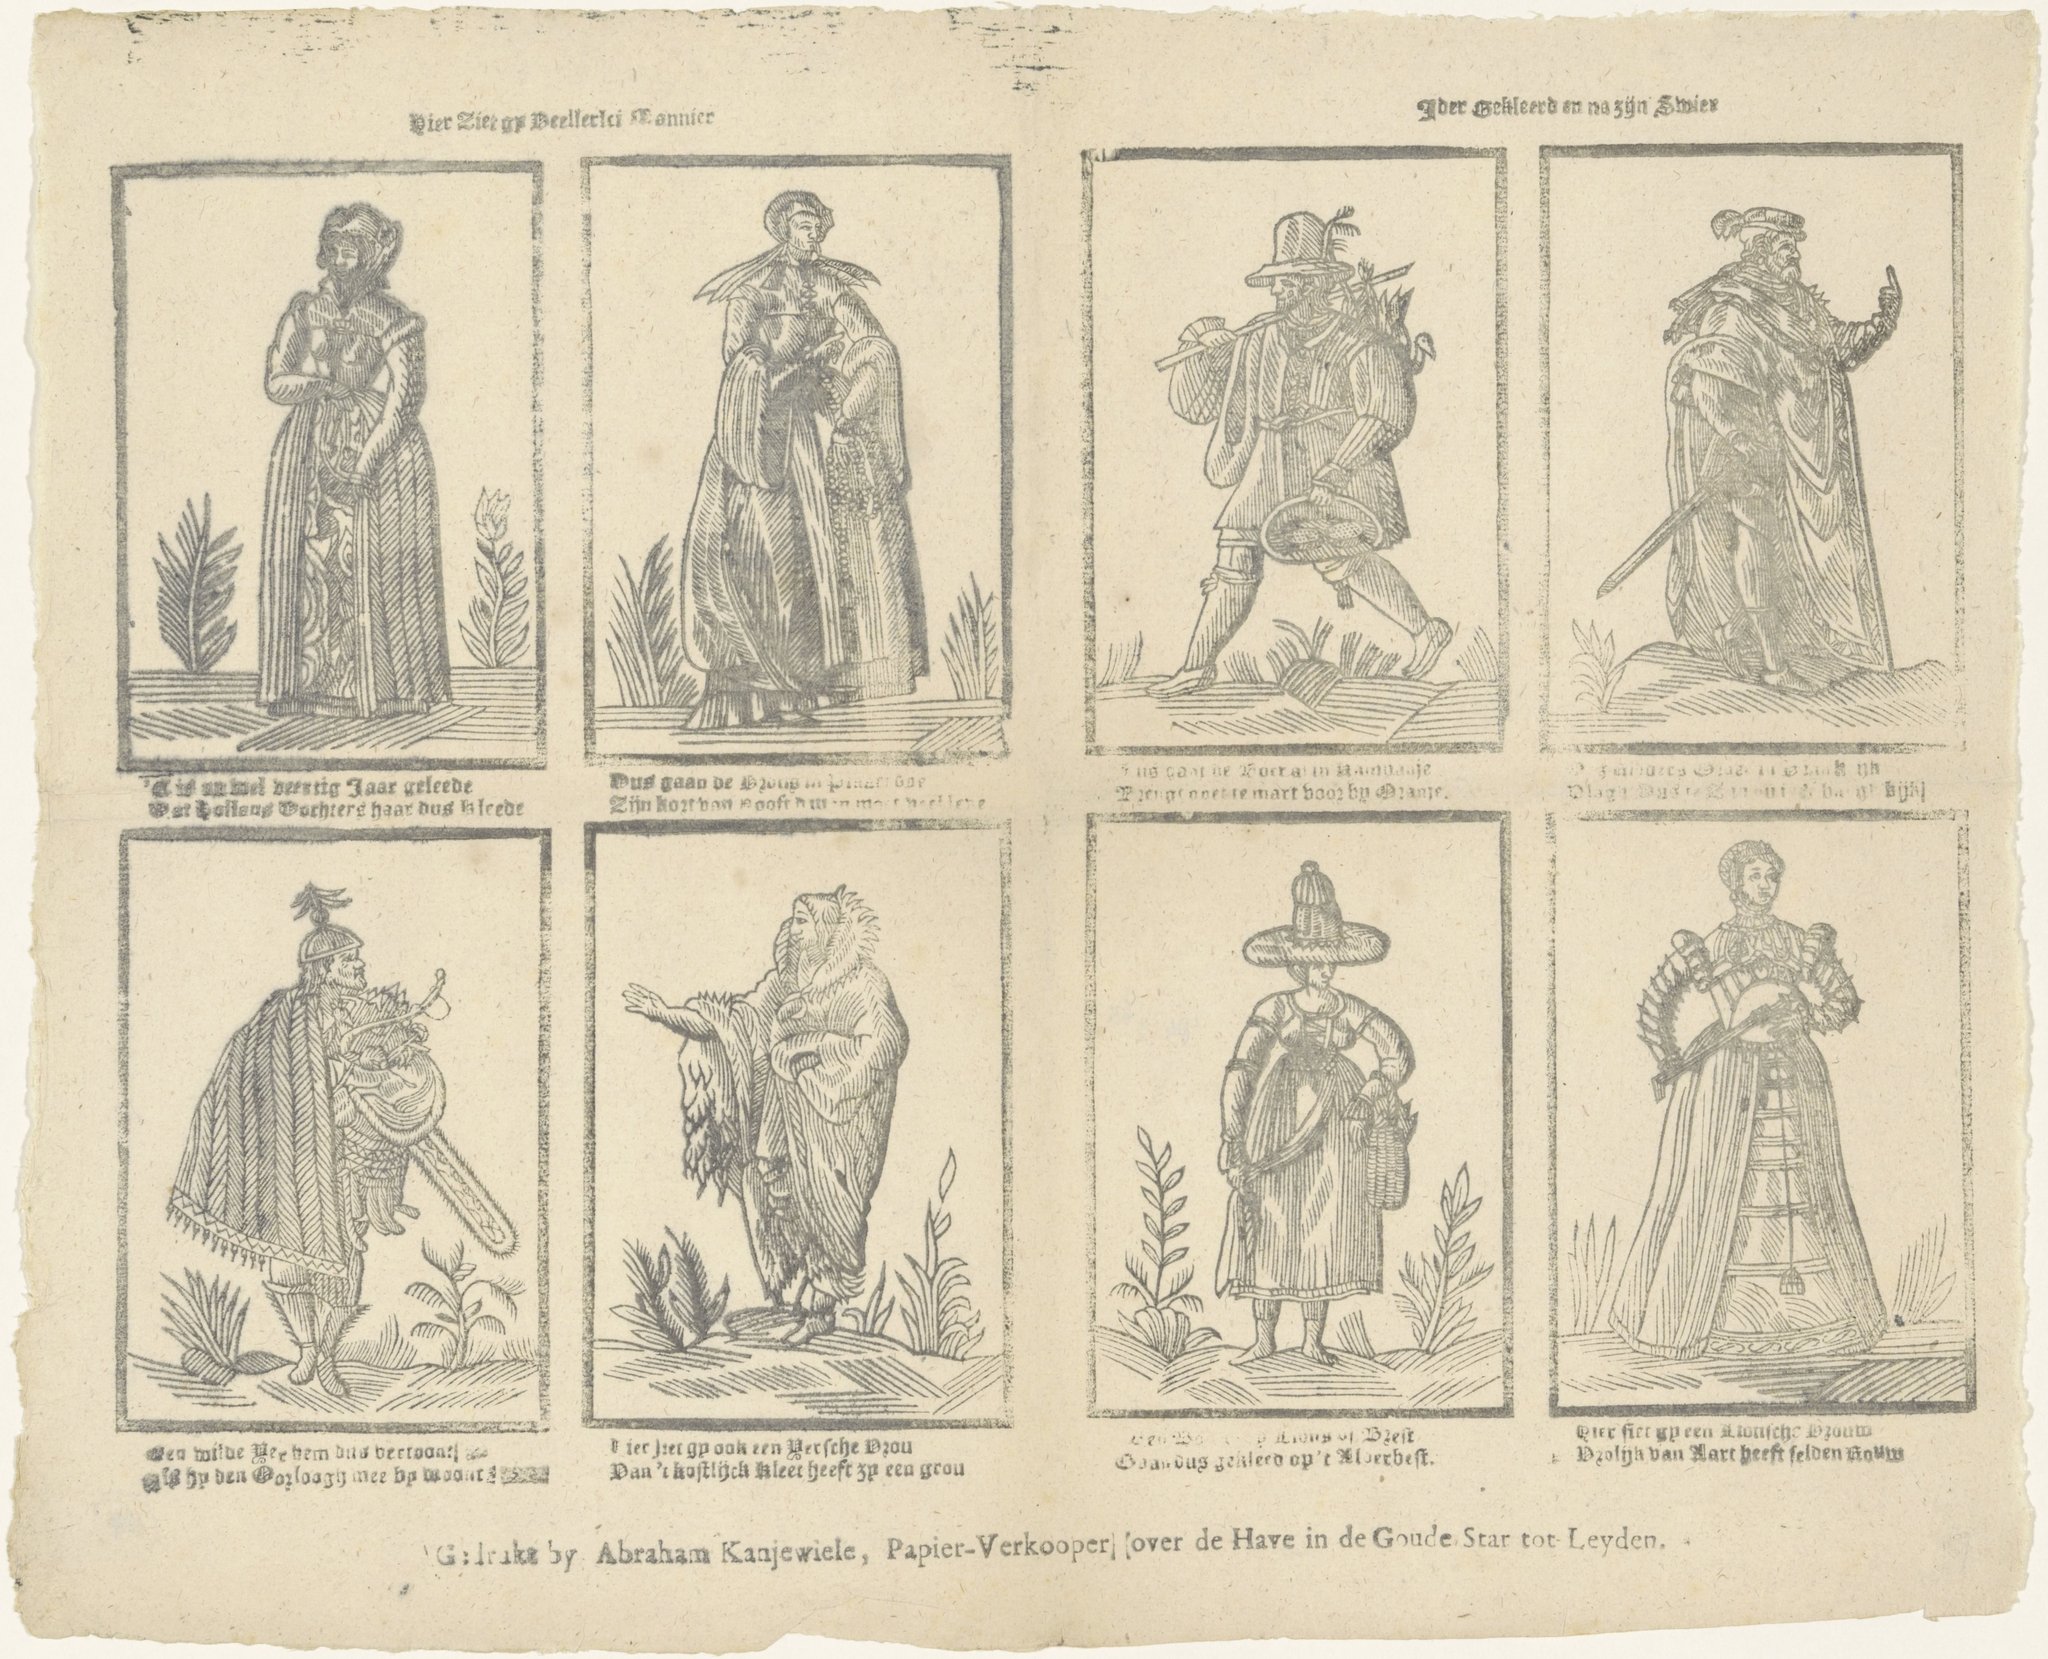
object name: popular print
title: Hier ziet gij Veelerlei Mannier / Ider Gekleerd en na zijn Swier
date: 1690-1718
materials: paper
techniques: letterpress printing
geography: leiden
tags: historical costume, folk costume, regional costume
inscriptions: collector's mark: Lugt 2760, collector's mark: Lugt 2228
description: Blad met 8 voorstellingen van Nederlandse en vreemde klederdracht uit het midden van de zeventiende eeuw. Onder elke voorstelling een tweeregelig vers.